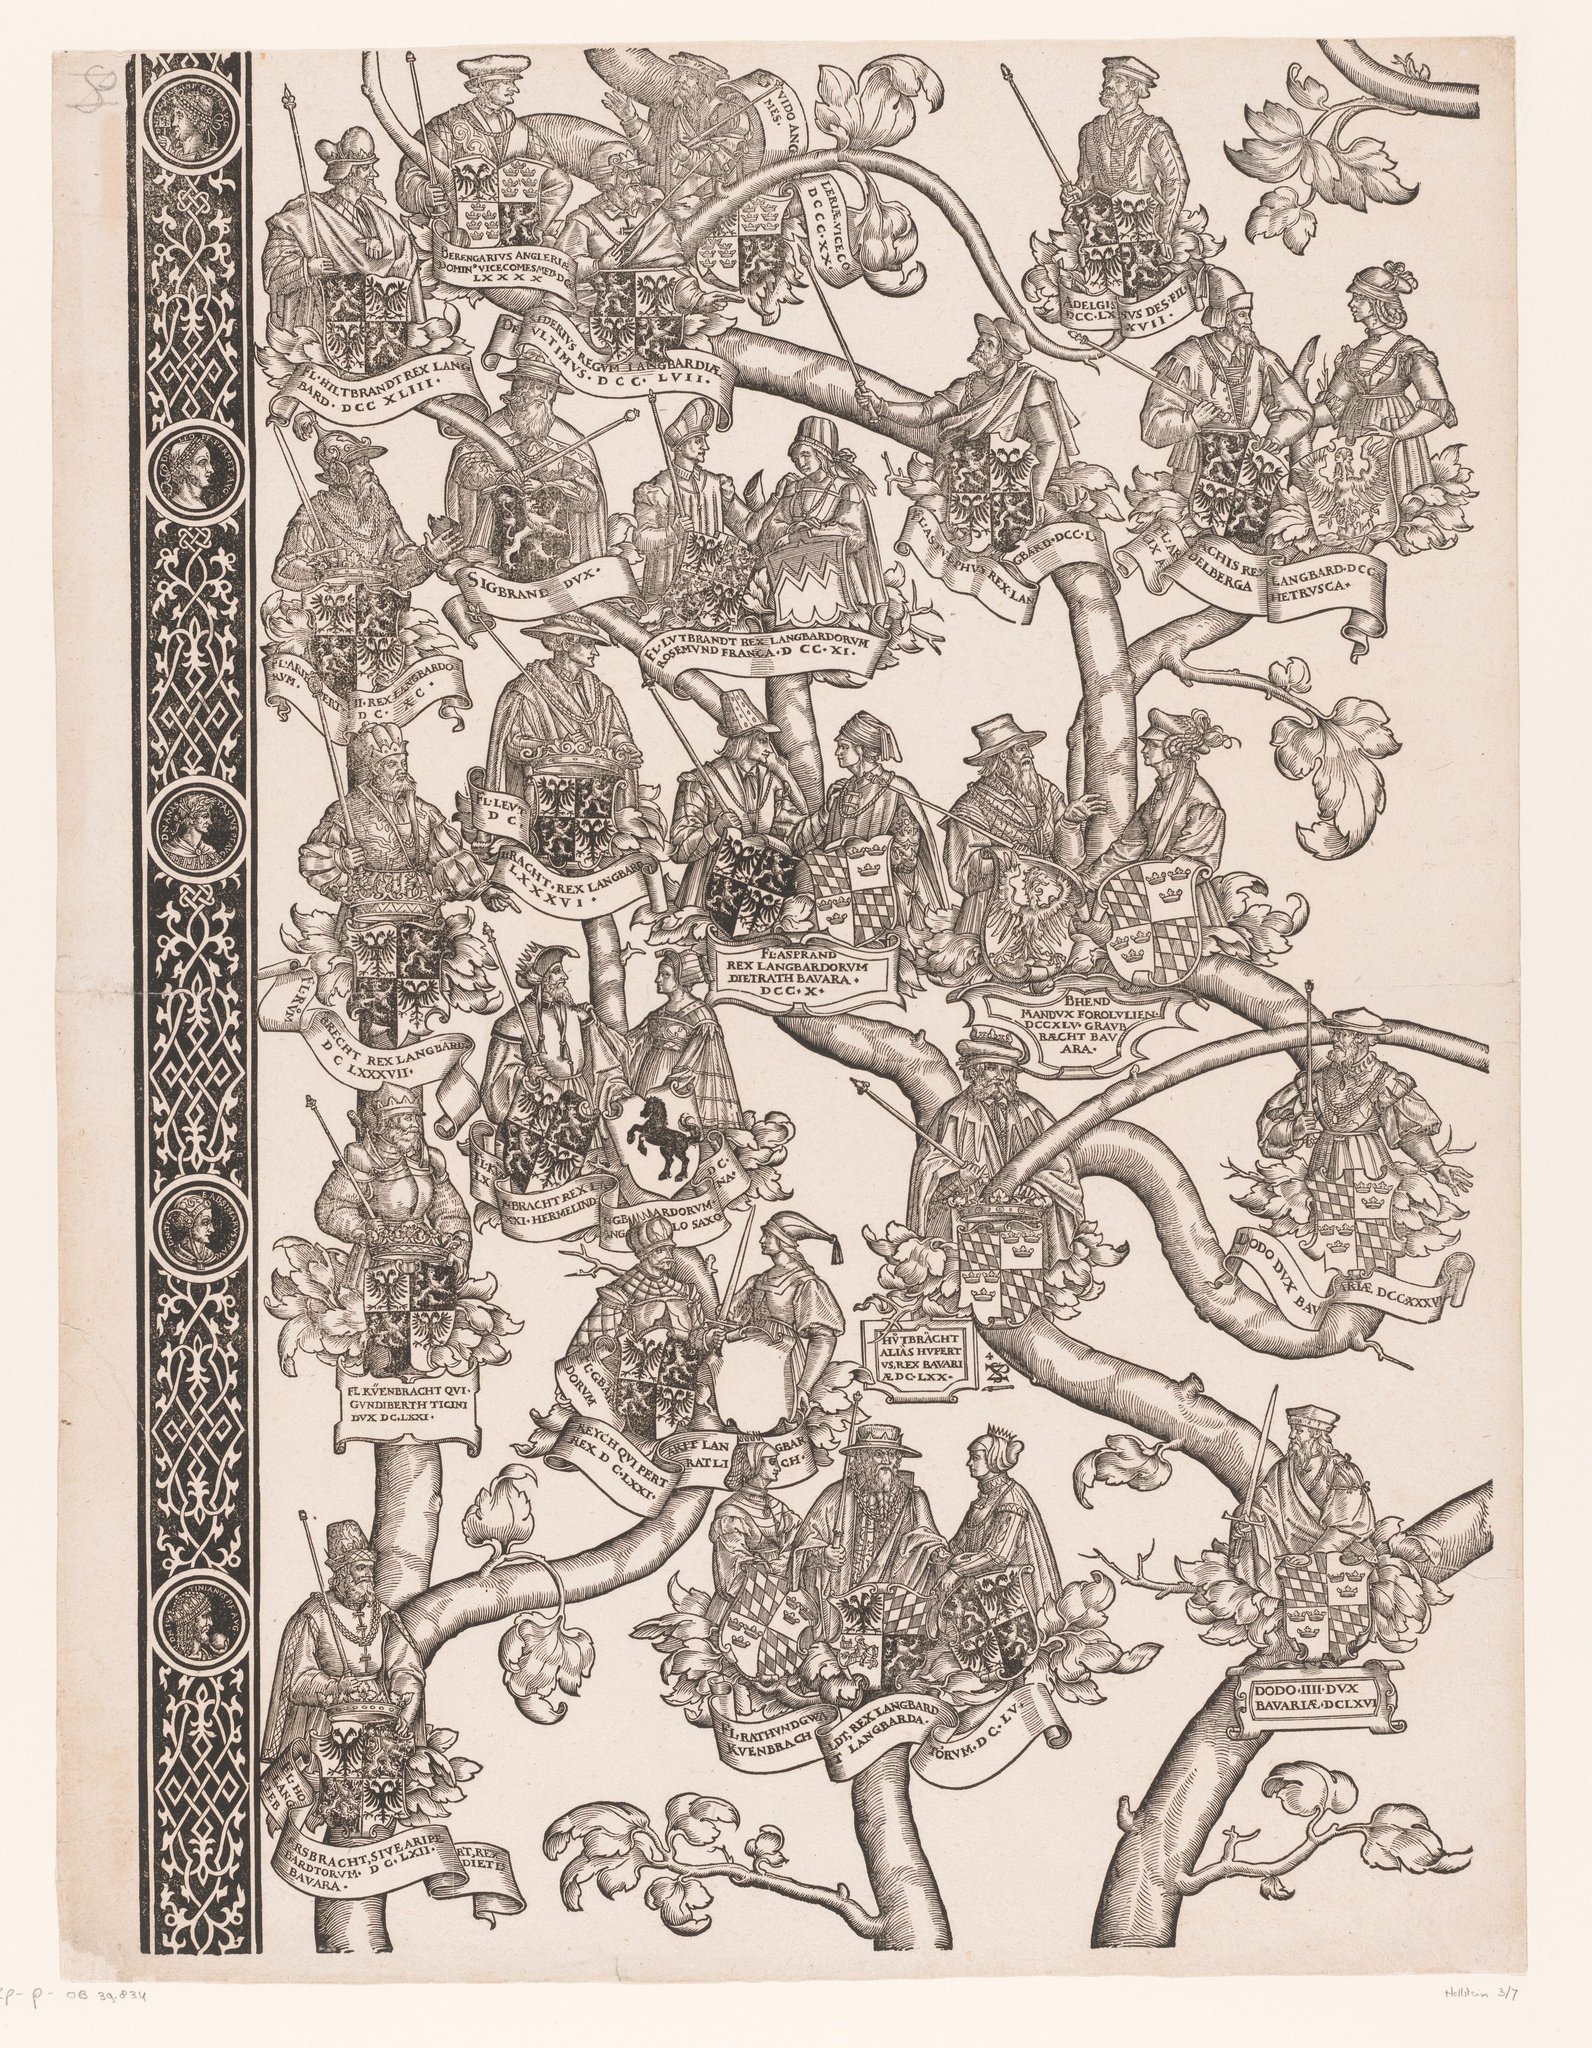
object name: print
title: Stamboom van Frederik en Ottheinrich van Palts-Neuburg (plaat 7)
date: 1535-1594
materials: paper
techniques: letterpress printing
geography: basel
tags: earl, family lineage, pedigree, genealogical tree or table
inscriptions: collector's mark: Lugt 240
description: Blad 7 van een stamboom bestaande uit 21 bladen, gedrukt van 42 blokken.